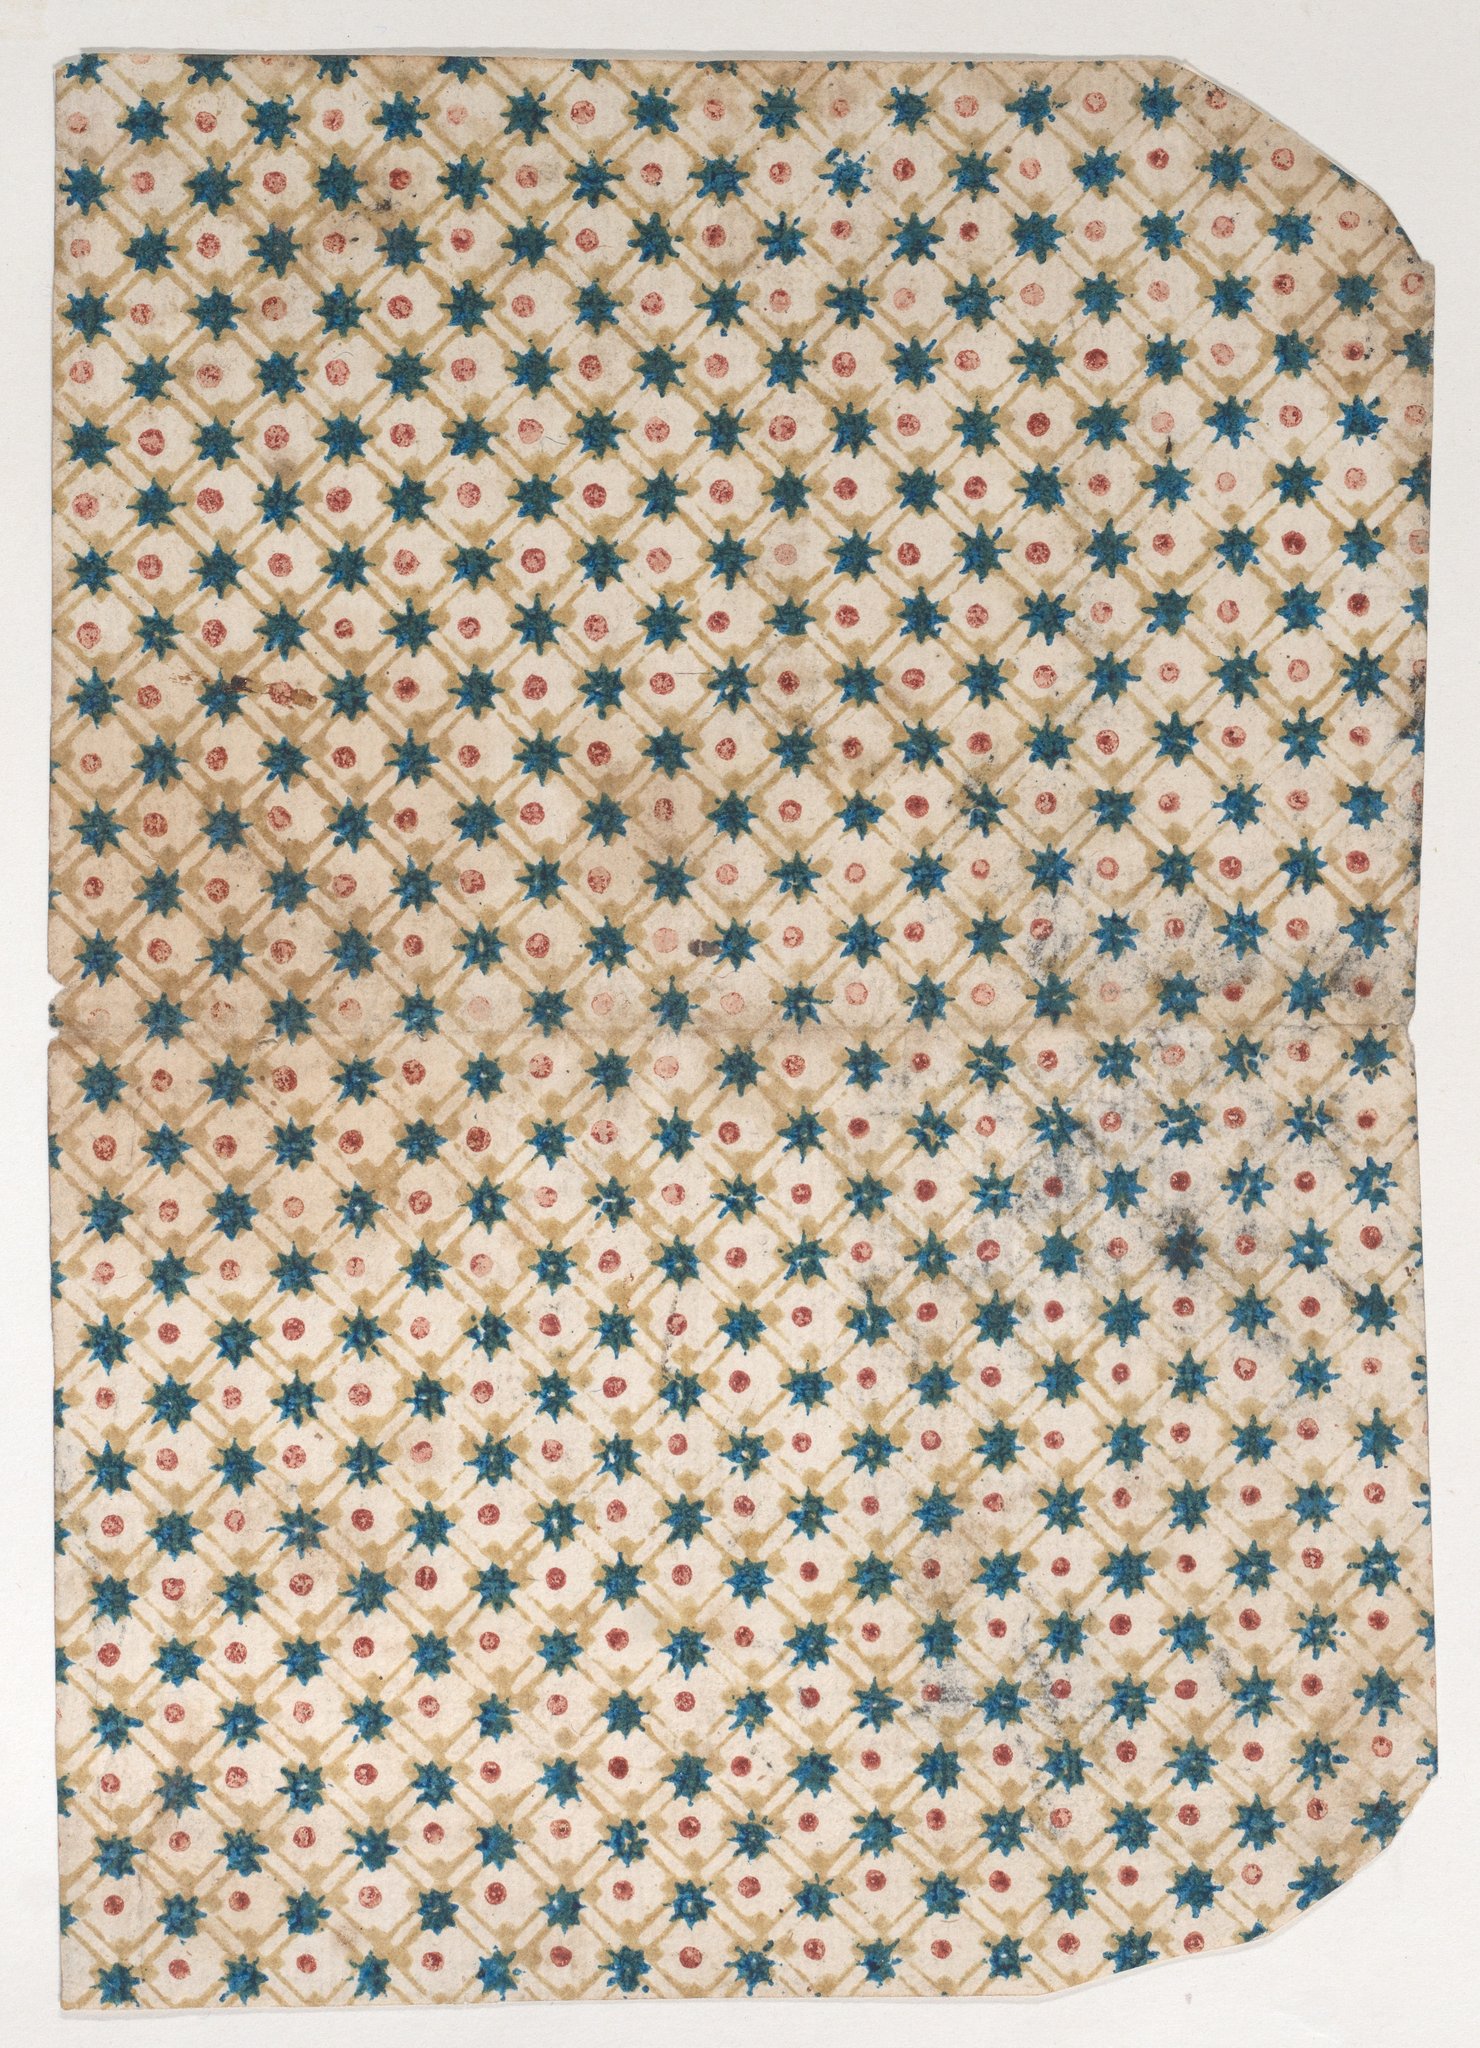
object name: print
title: Book cover with overall pattern of stars and dots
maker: Anonymous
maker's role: artist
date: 1801-1900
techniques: relief print